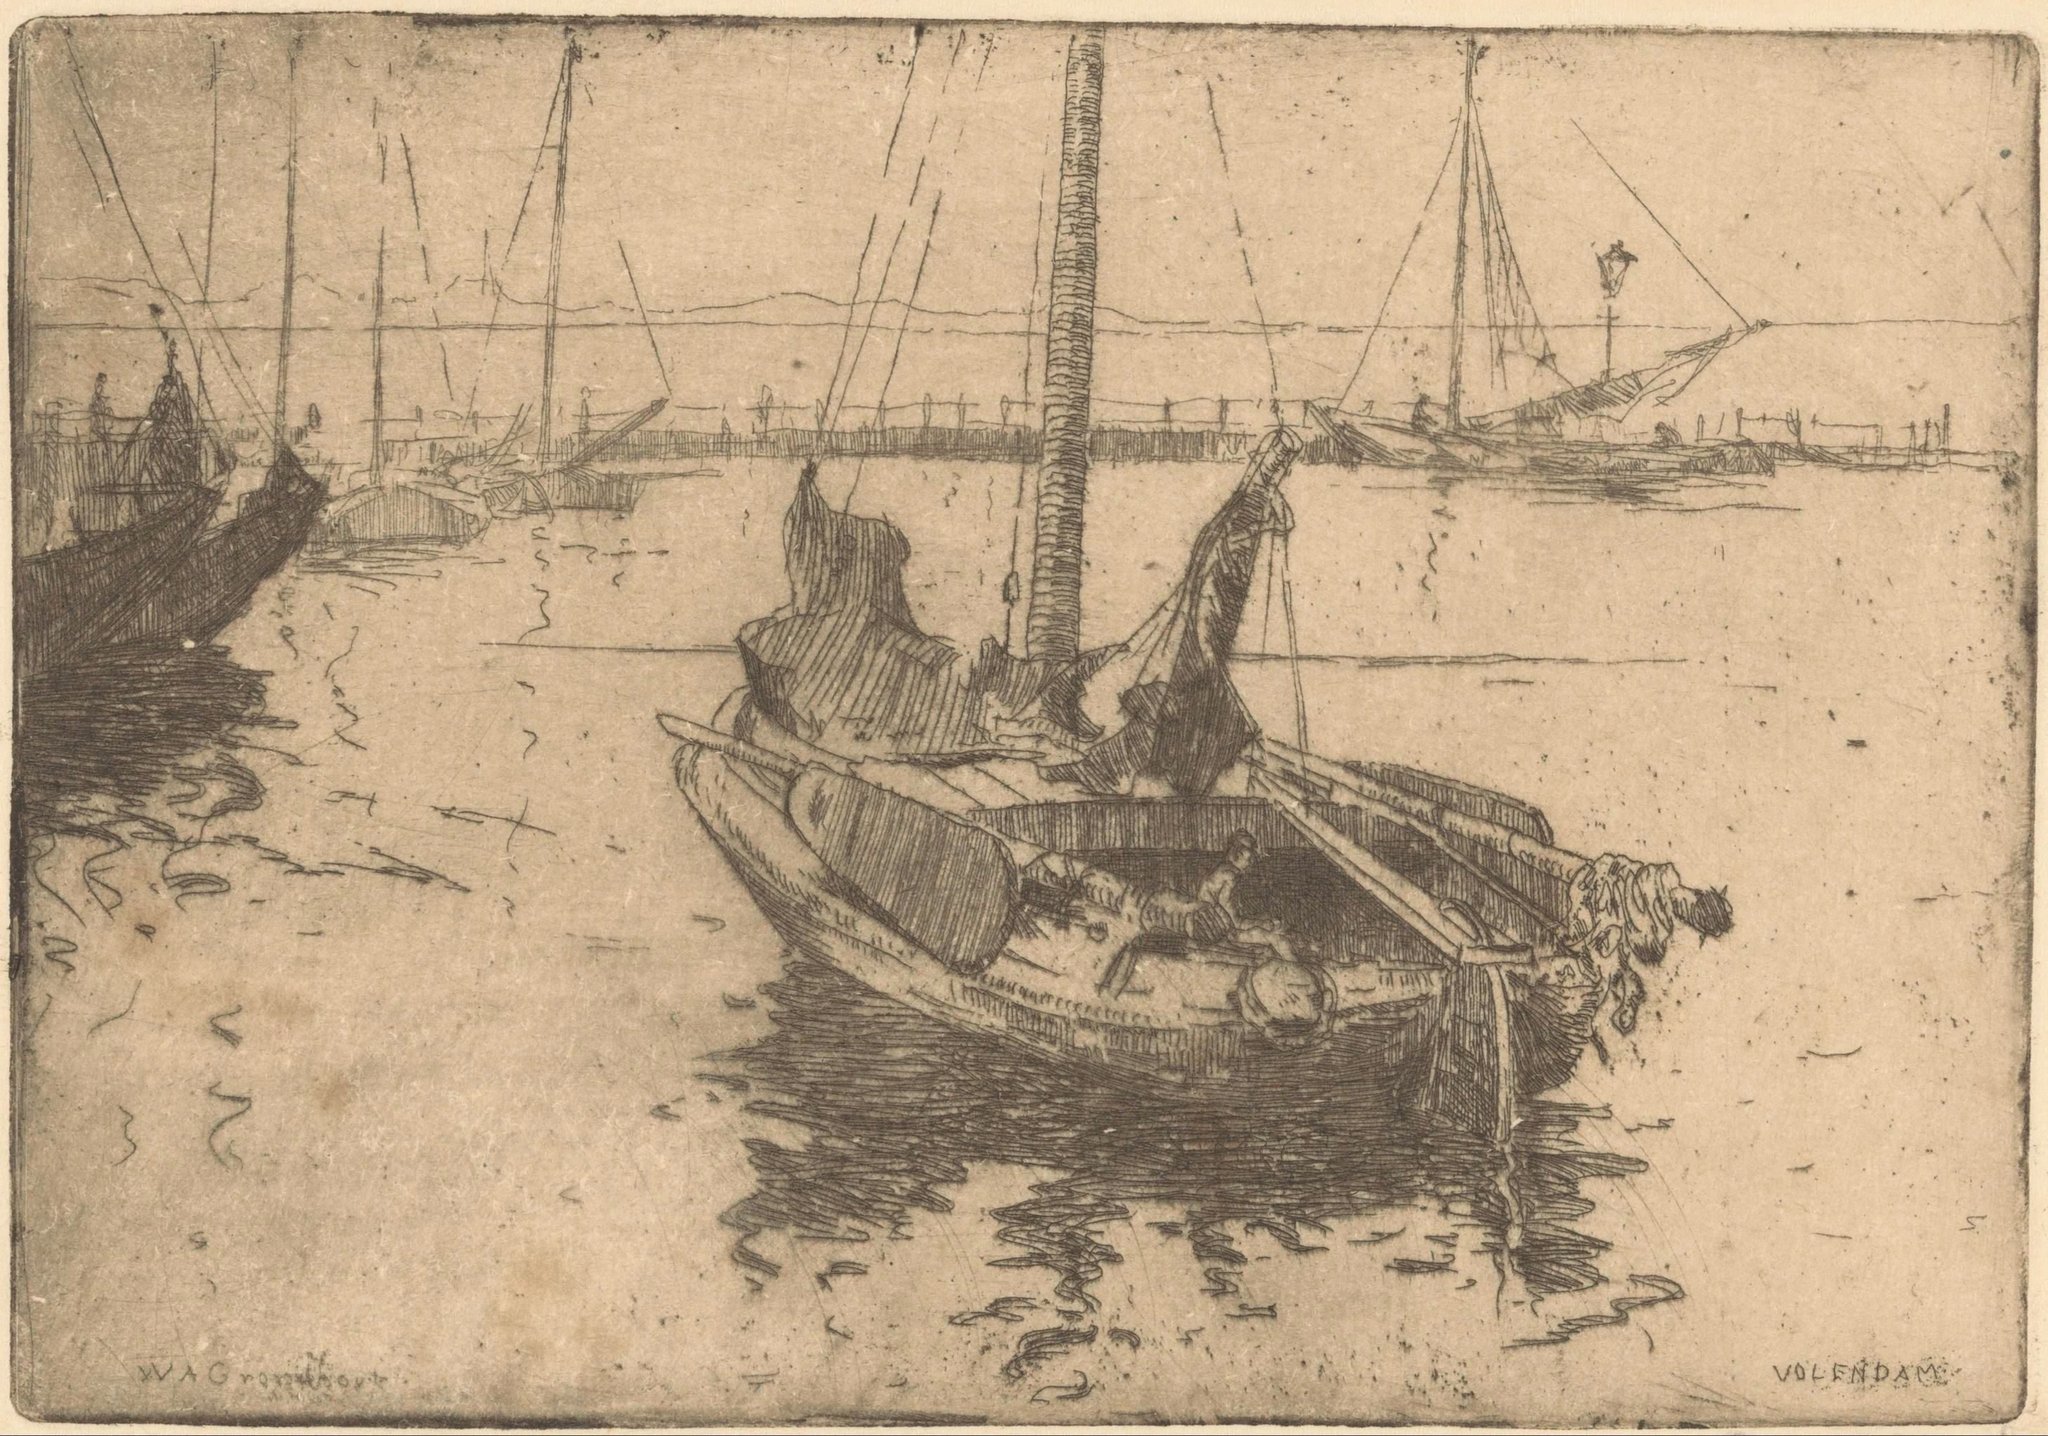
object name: print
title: Schuiten in de haven van Volendam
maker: willem adrianus grondhout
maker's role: draughtsman, painter, print maker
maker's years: 1878-1934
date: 1888-1934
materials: paper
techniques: etching, intaglio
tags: harbour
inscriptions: collector's mark: Lugt 2228